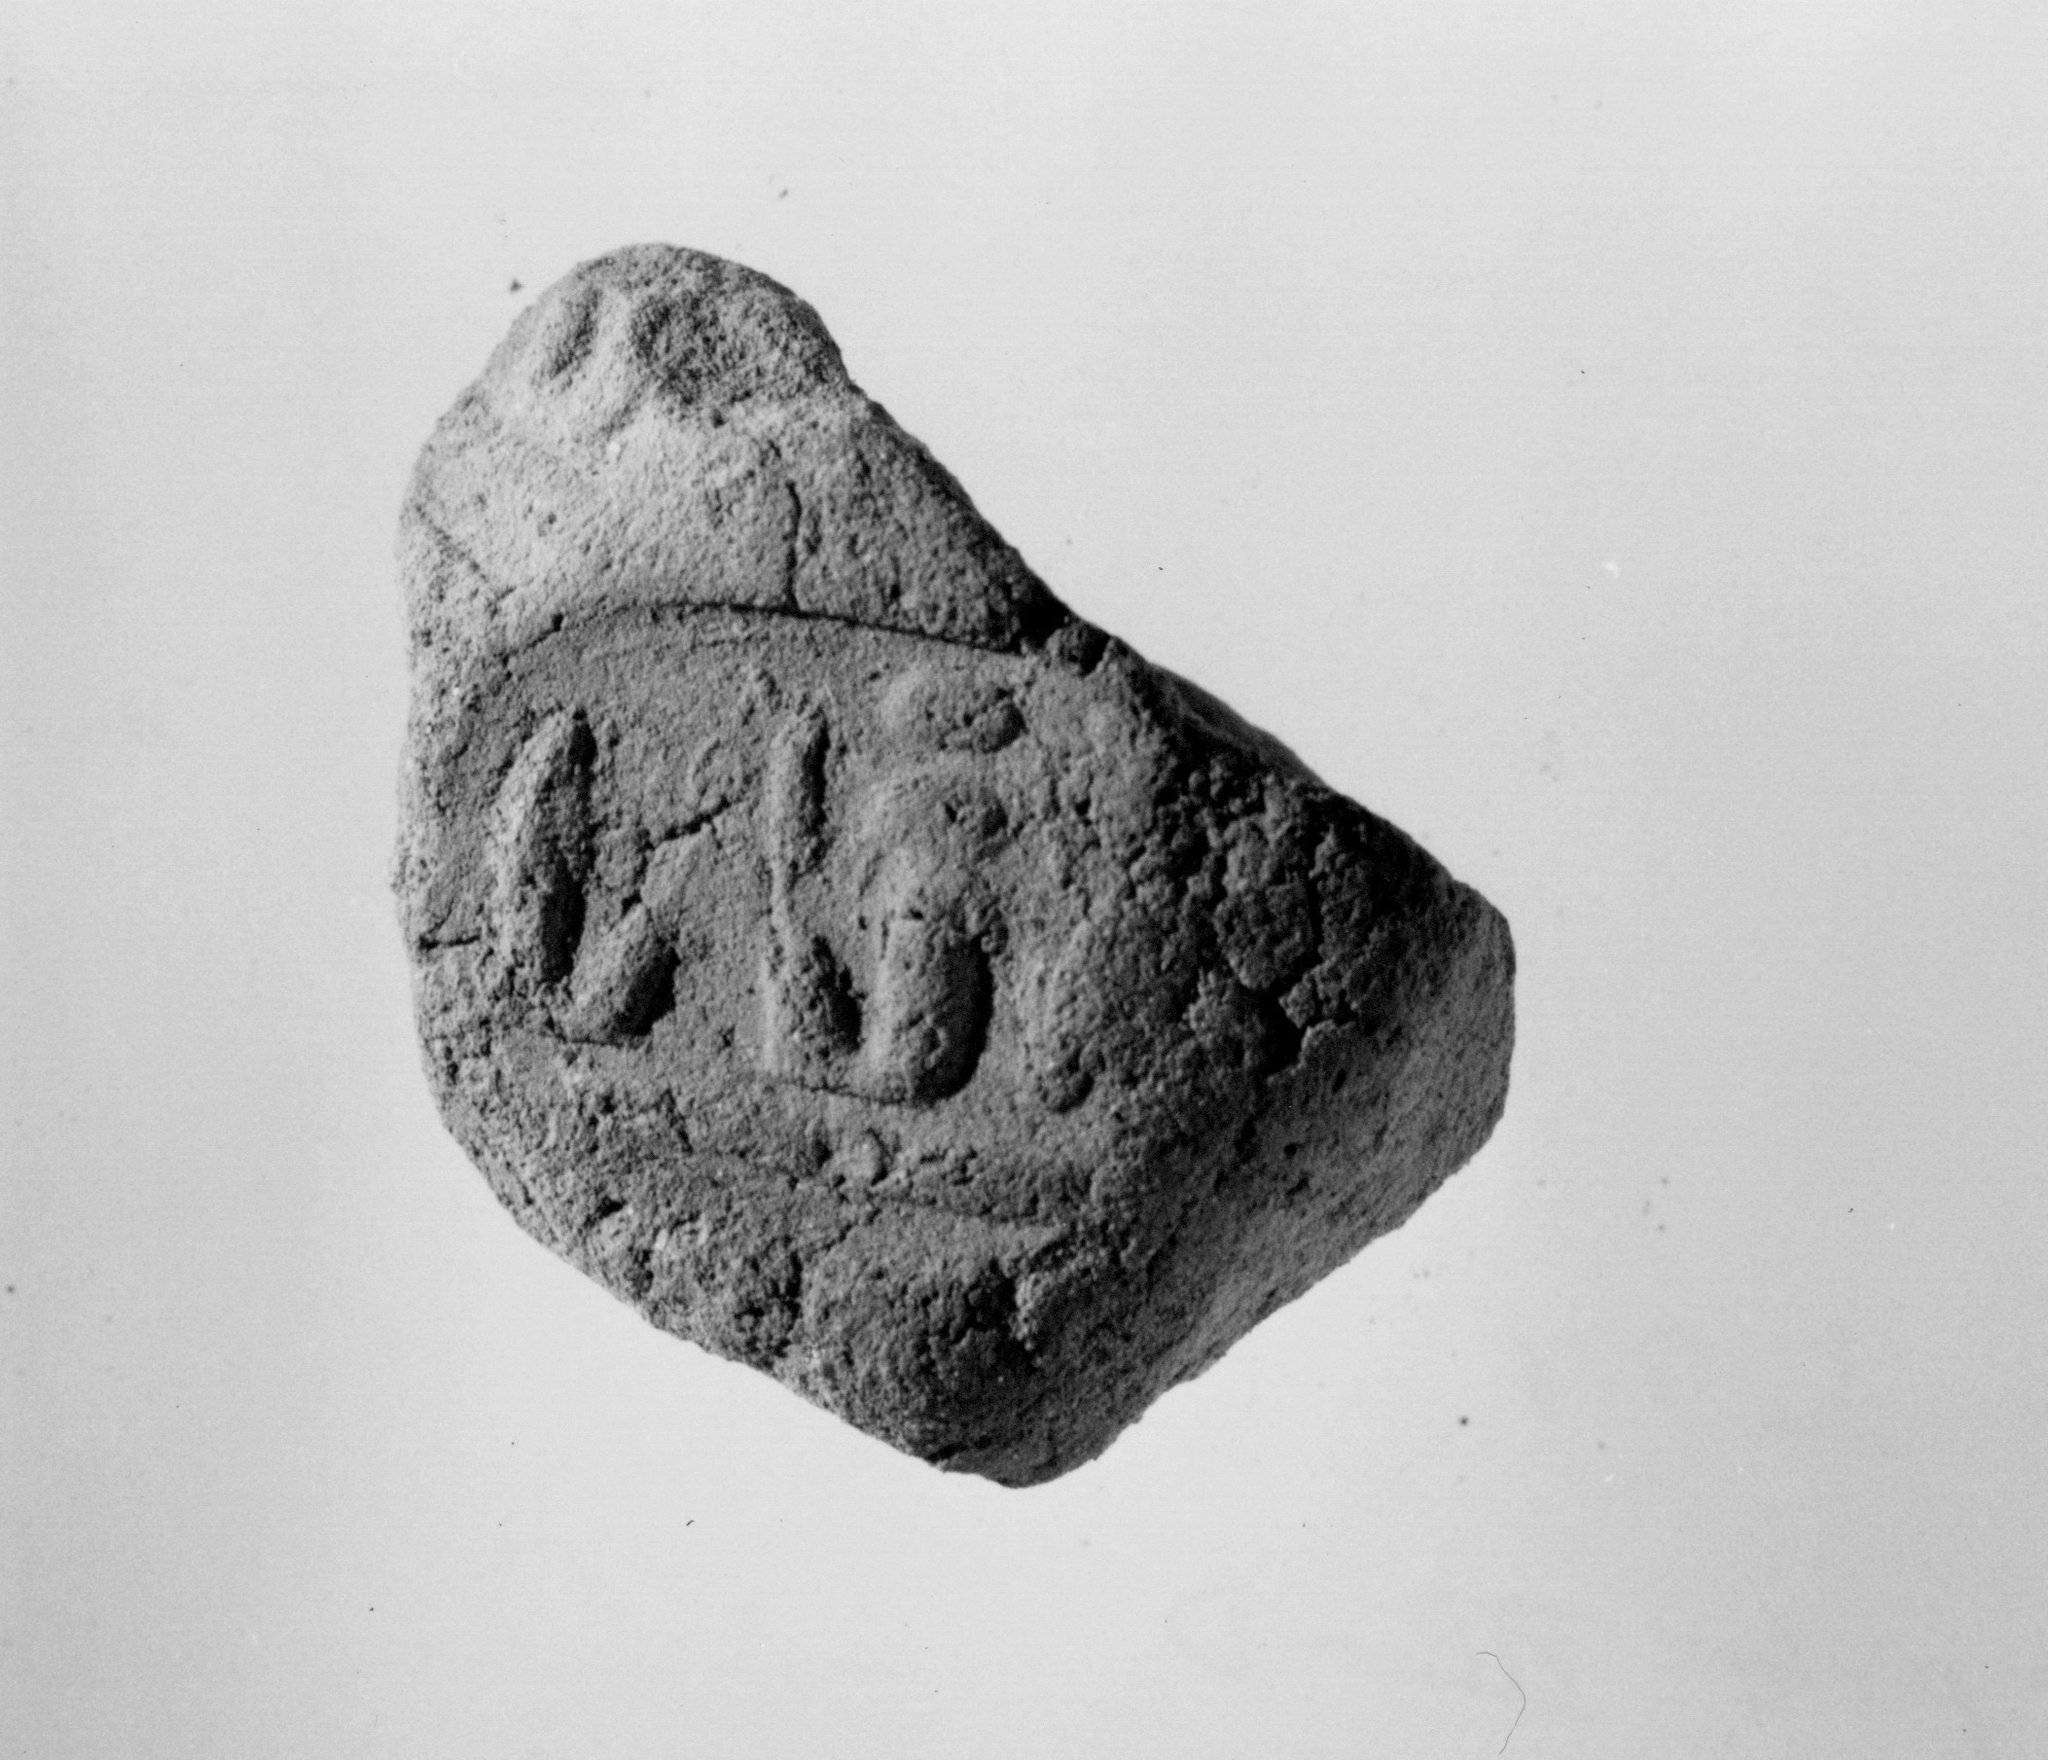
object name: sealing, nebmaatre, amenhotep iii, thoth, double crown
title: Document Sealing With the Throne Name of Amenhotep III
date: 1390-1352 BCE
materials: mud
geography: egypt